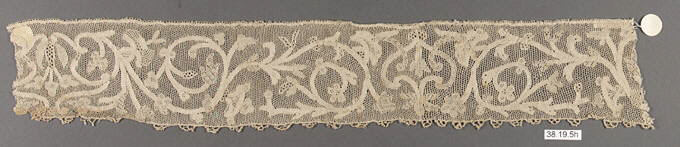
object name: hebrew ritual lace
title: Hebrew ritual lace (one of four)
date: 1701-1733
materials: silk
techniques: lace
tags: flowers